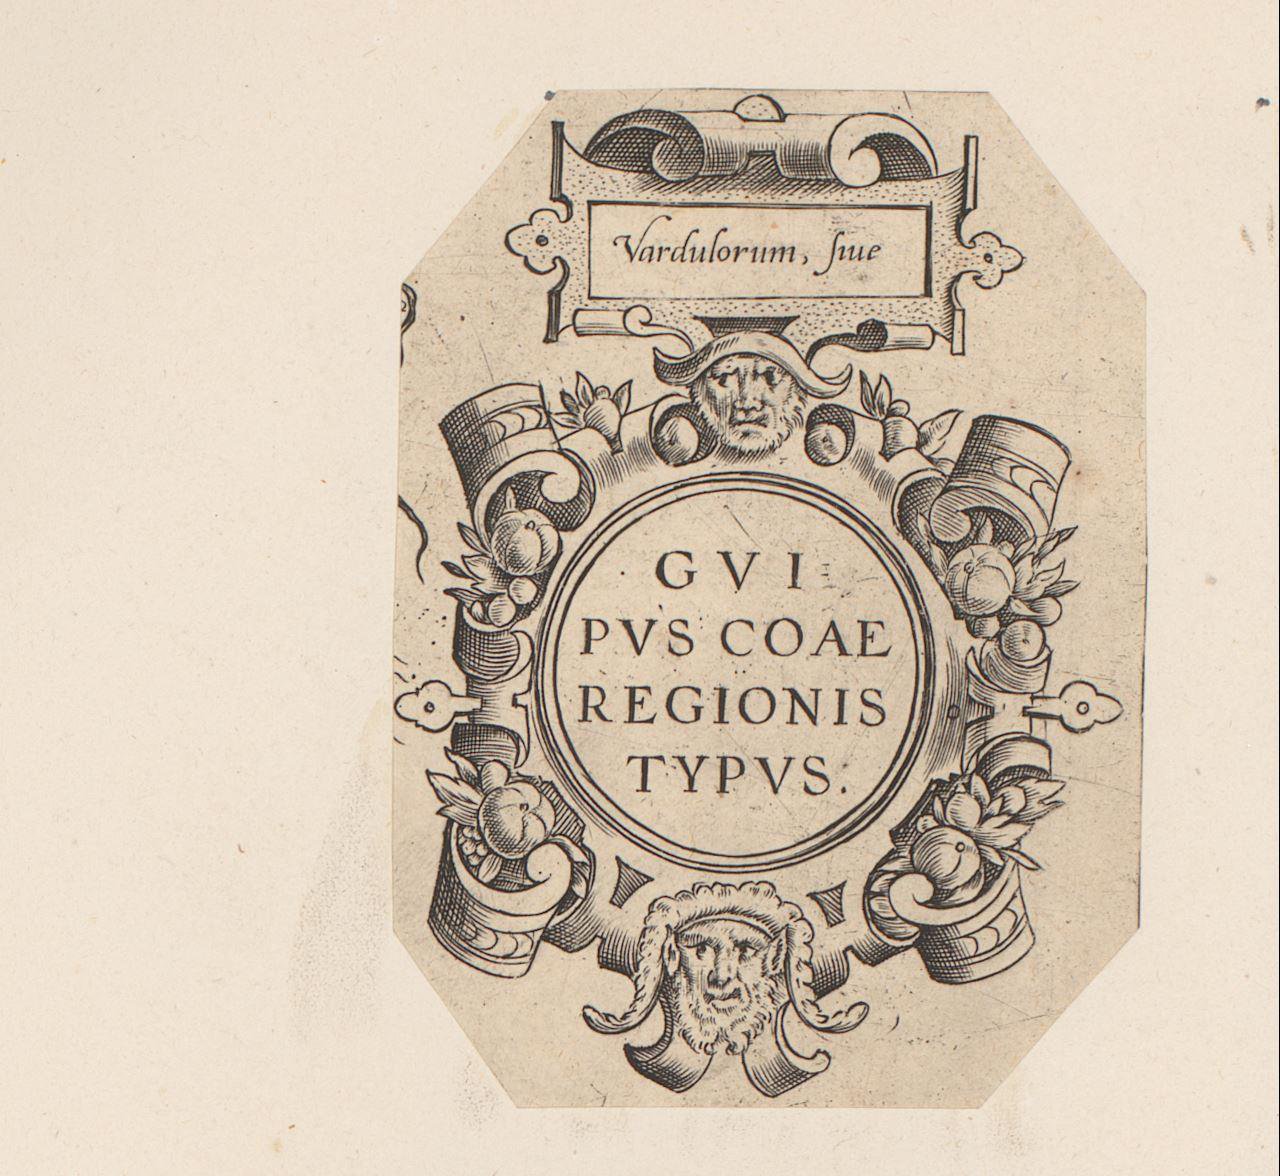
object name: album leaf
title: Ronde cartouche met twee maskers en trossen fruit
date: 1584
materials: paper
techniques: engraving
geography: antwerp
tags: fruits and vegetables ~ ornament, ornament ~ cartouche, mask, mascaron ~ ornament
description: Ronde cartouche met twee maskers en trossen fruit. De cartouche is een fragment van een kaart van Gipuzkoa, De prent maakt deel uit van een album.